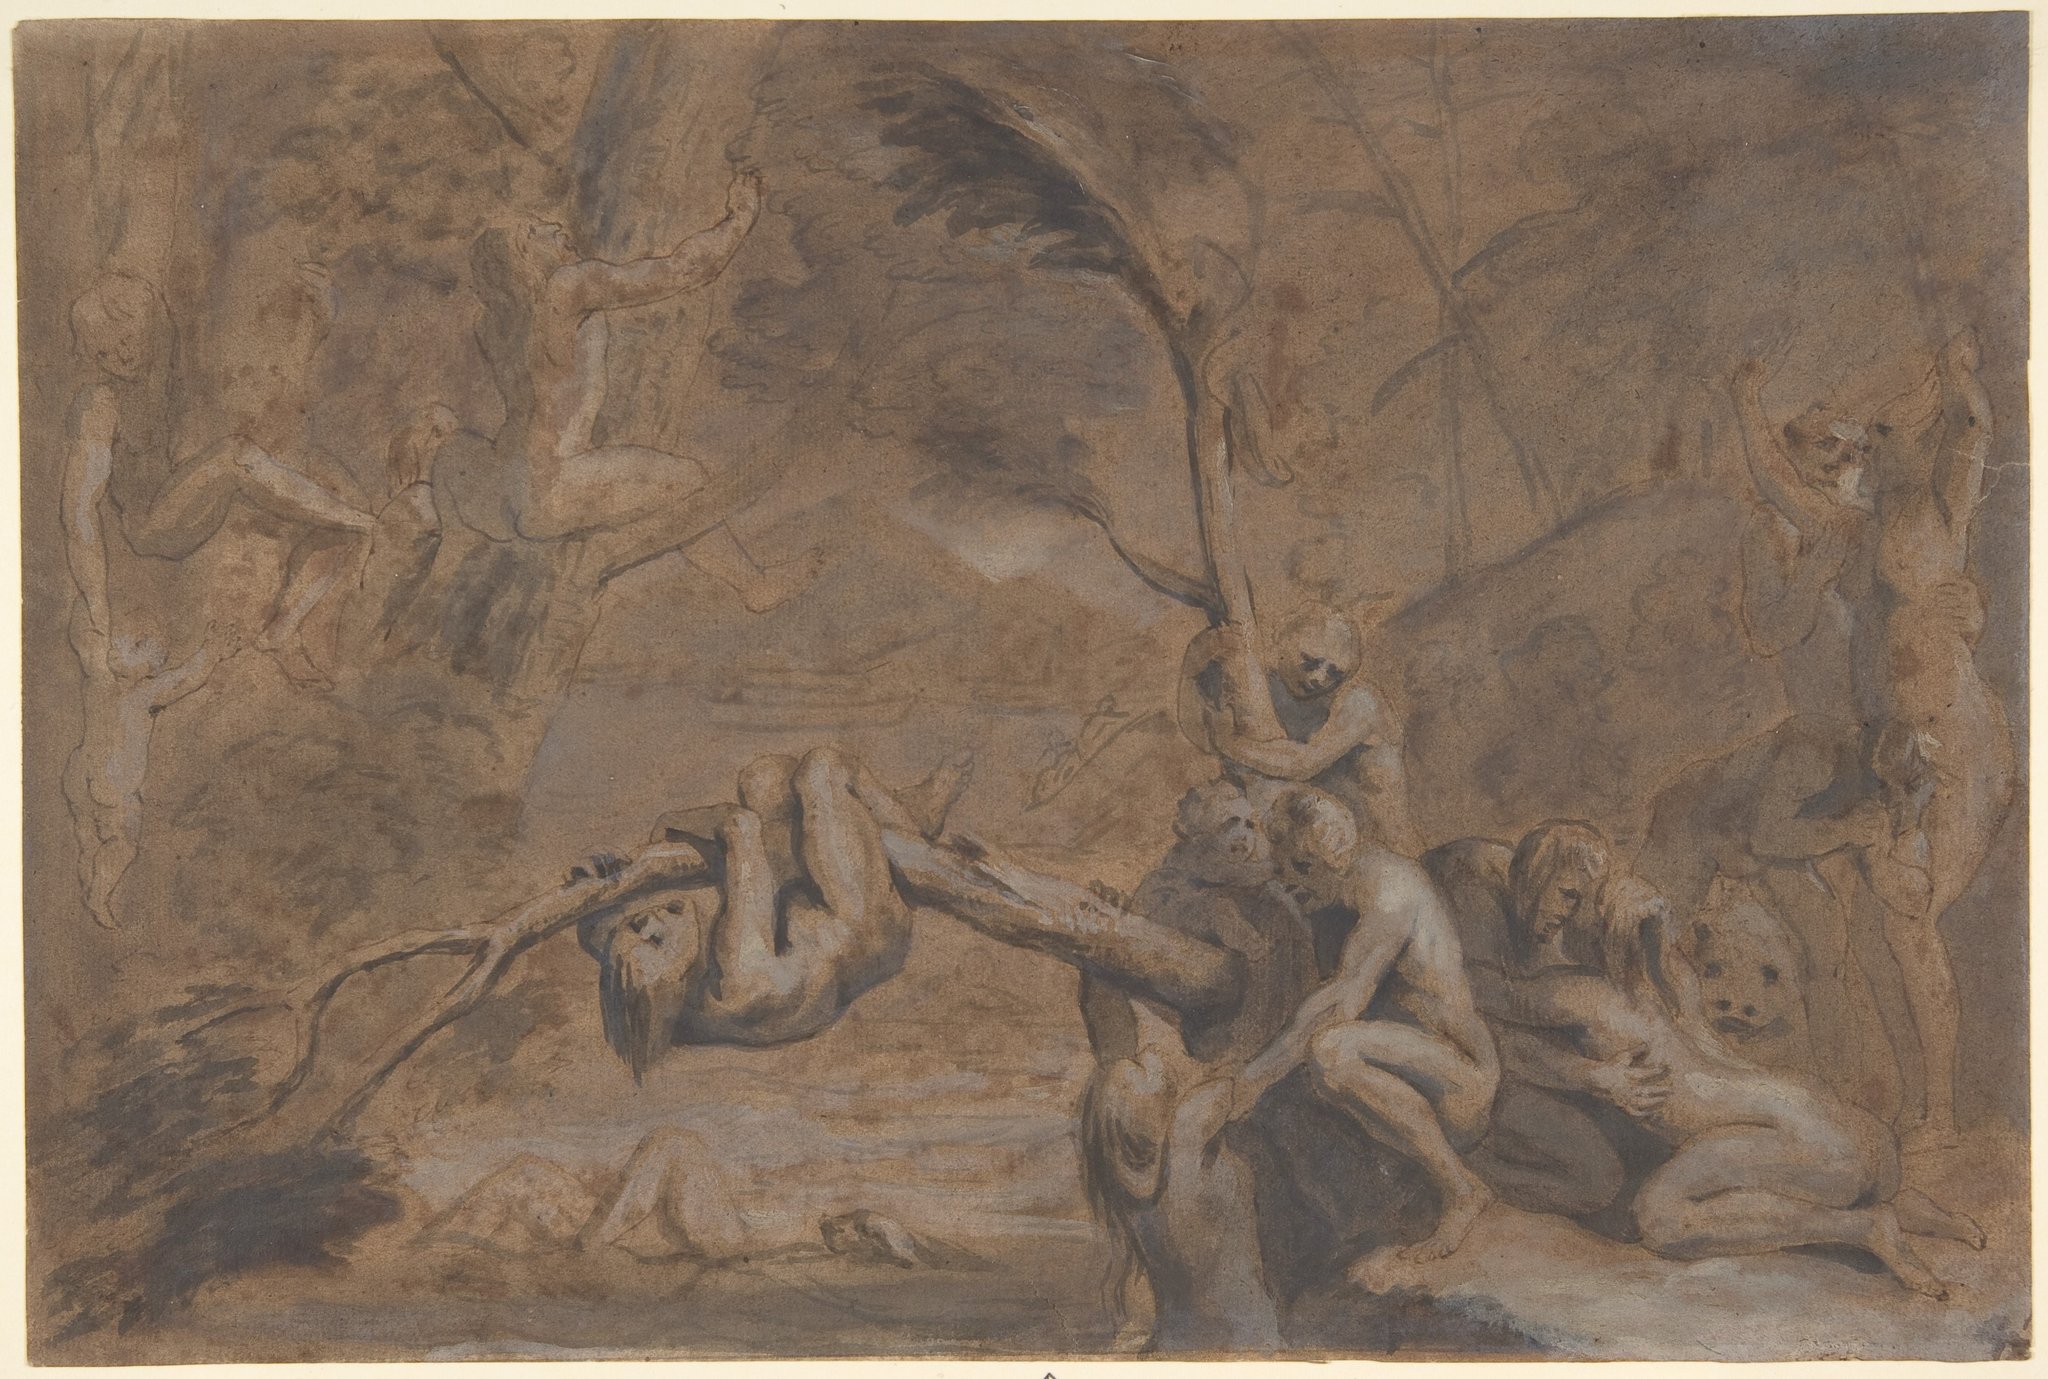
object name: drawing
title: The Flood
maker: jan cossiers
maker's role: artist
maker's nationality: flemish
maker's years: 1600-1671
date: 1615-1671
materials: ink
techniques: heightening, pen, wash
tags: suffering,children,men,women,floods